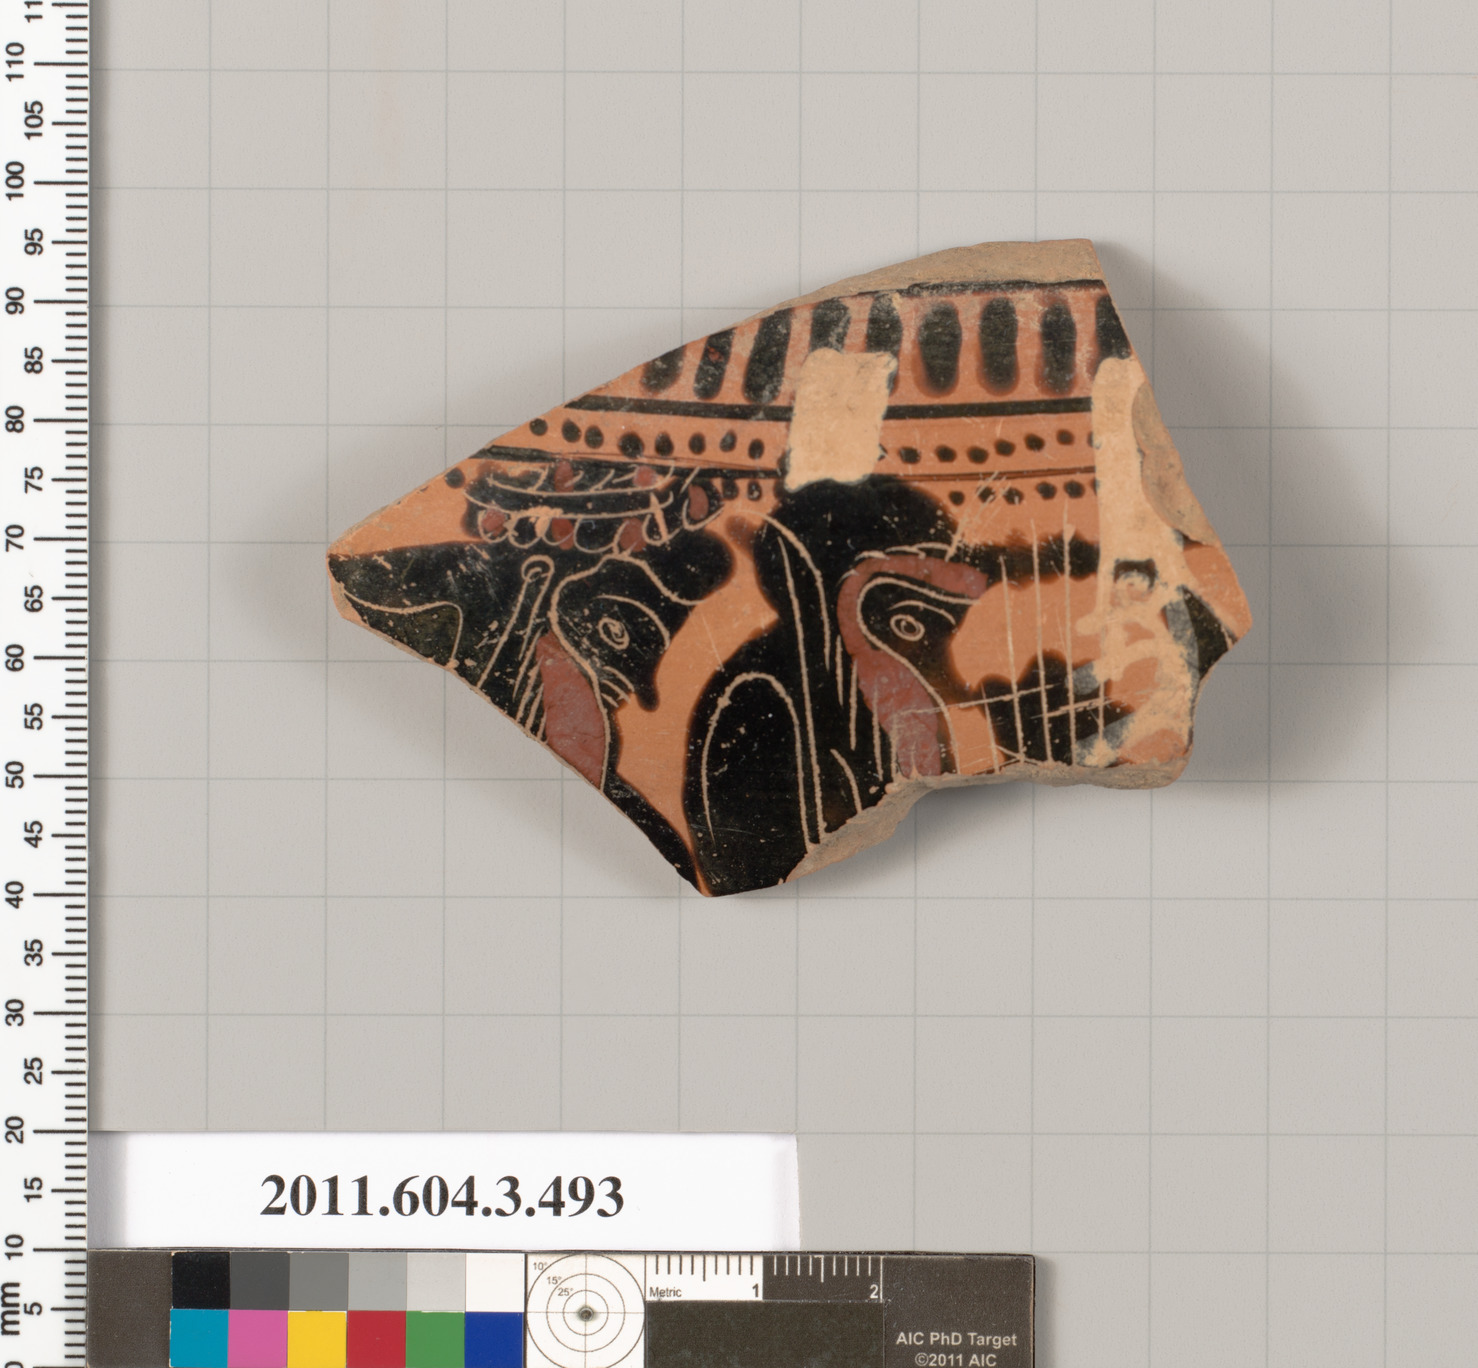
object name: column krater fragment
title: Terracotta fragment of a column-krater (bowl for mixing wine and water)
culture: greek, attic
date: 550-526 BCE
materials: terracotta